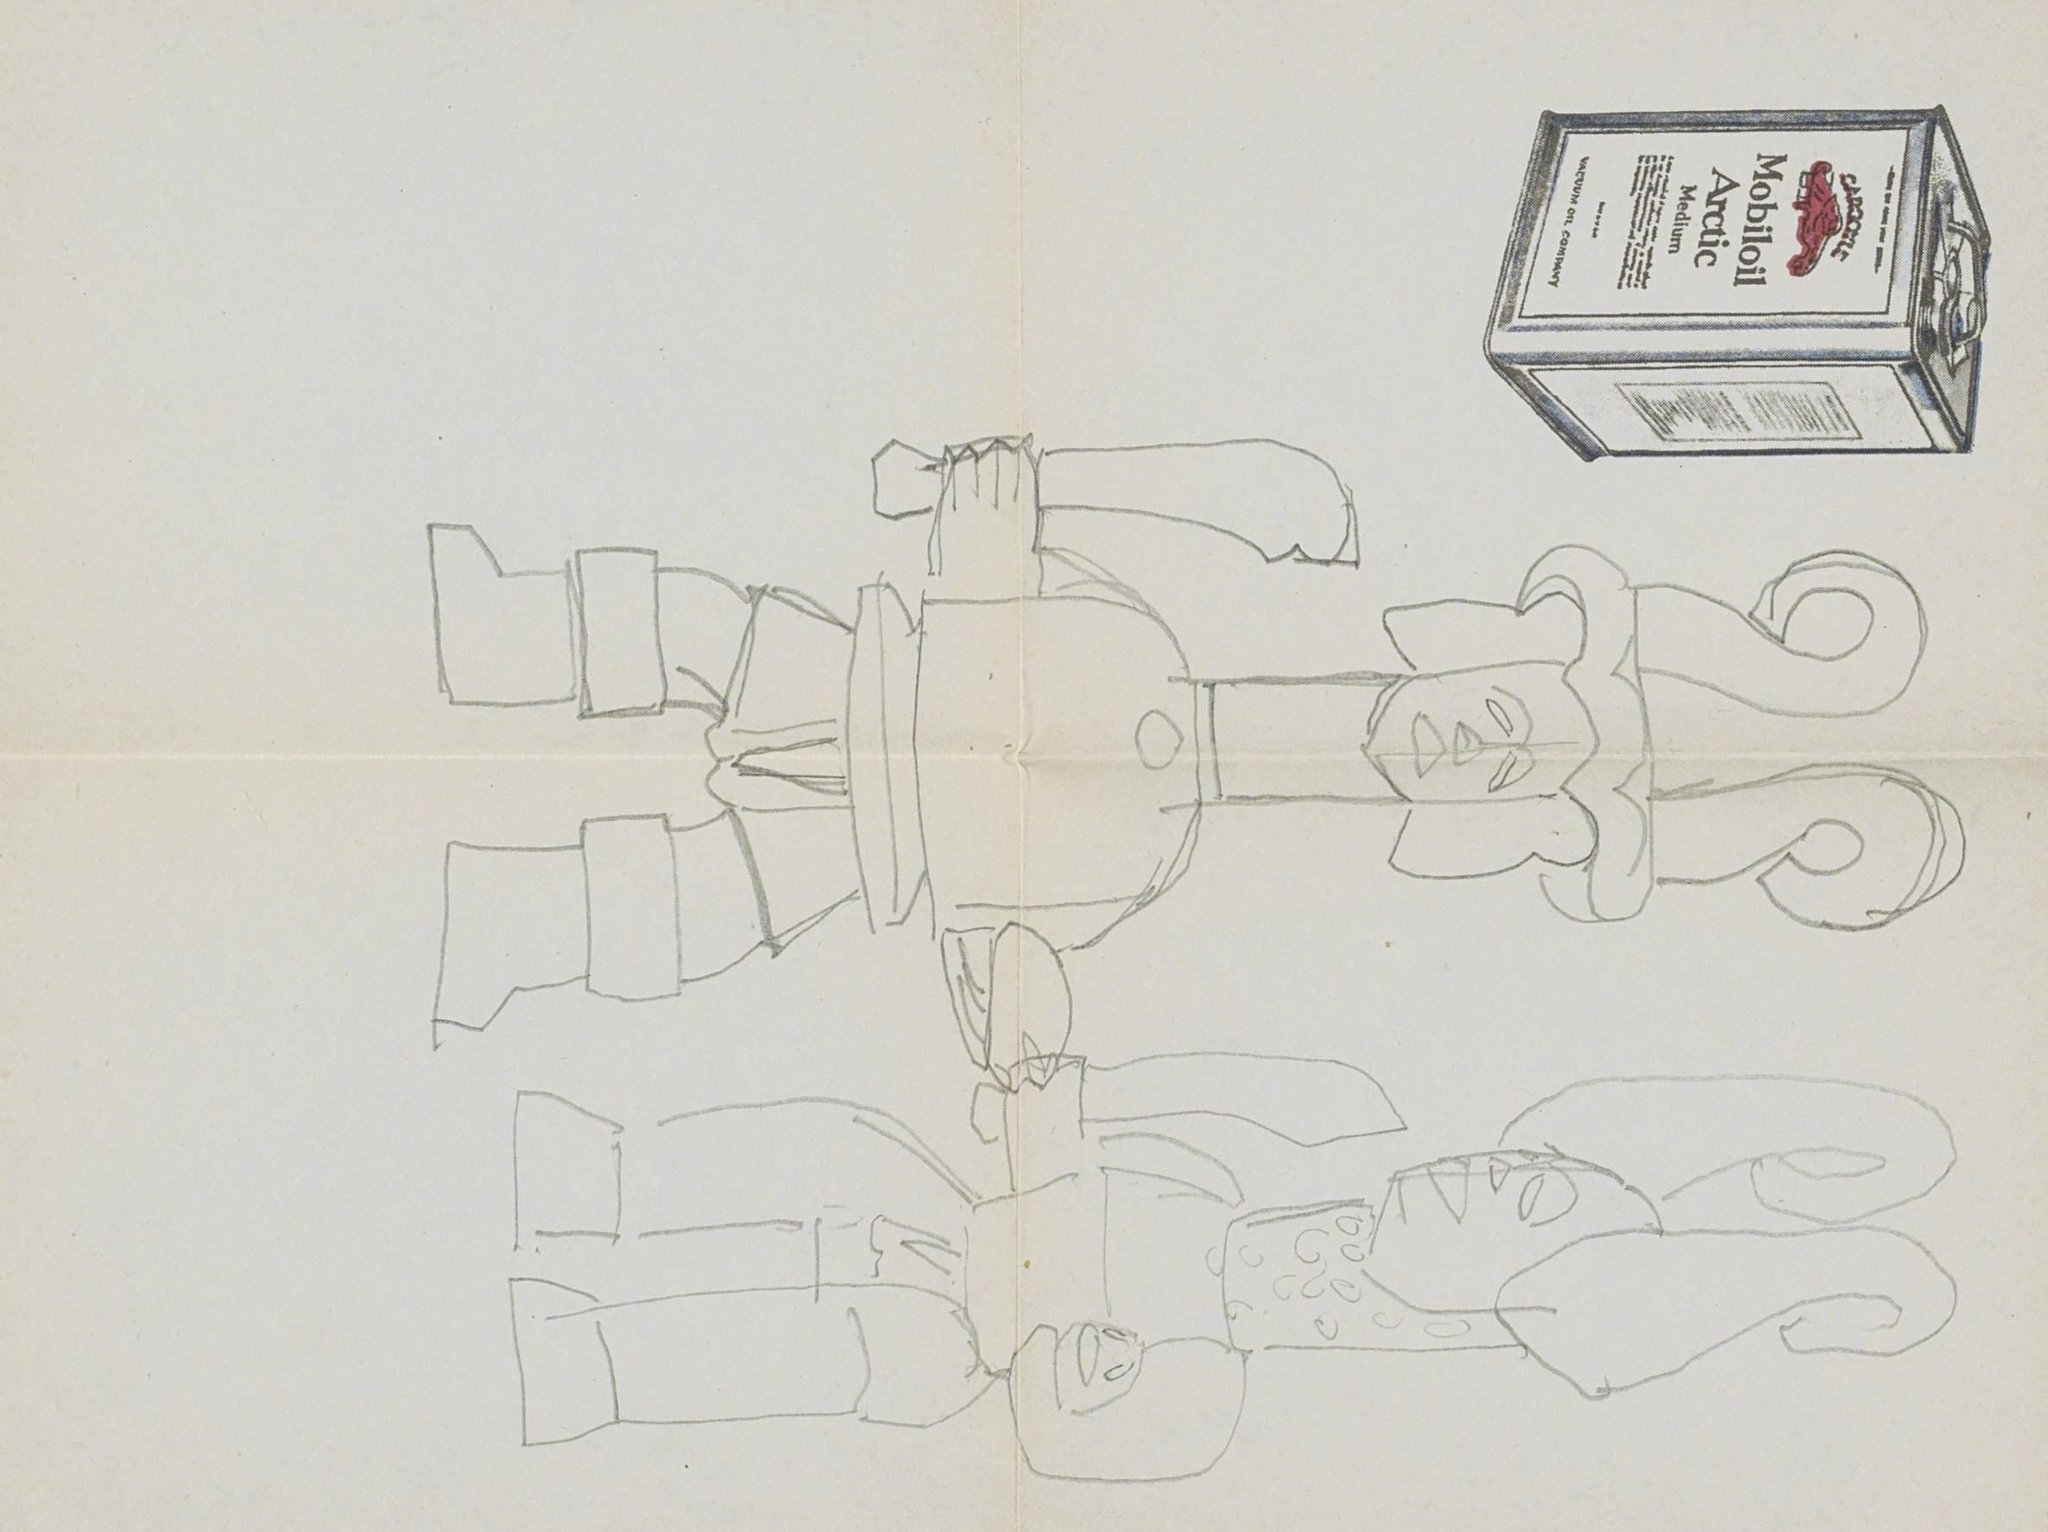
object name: sketchbook leaf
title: Twee Afrikaanse krijgers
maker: reijer stolk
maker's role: draughtsman, print maker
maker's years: 1896-1945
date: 1916-1945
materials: paper, pencil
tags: africans, warfare; military affairs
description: De figuren dragen speren en hoofddeksels. Mogelijk tekeningen naar beeldhouwwerken. Losse tekening tussen blad 27 verso en 28 recto uit een schetsboek met 60 bladen.